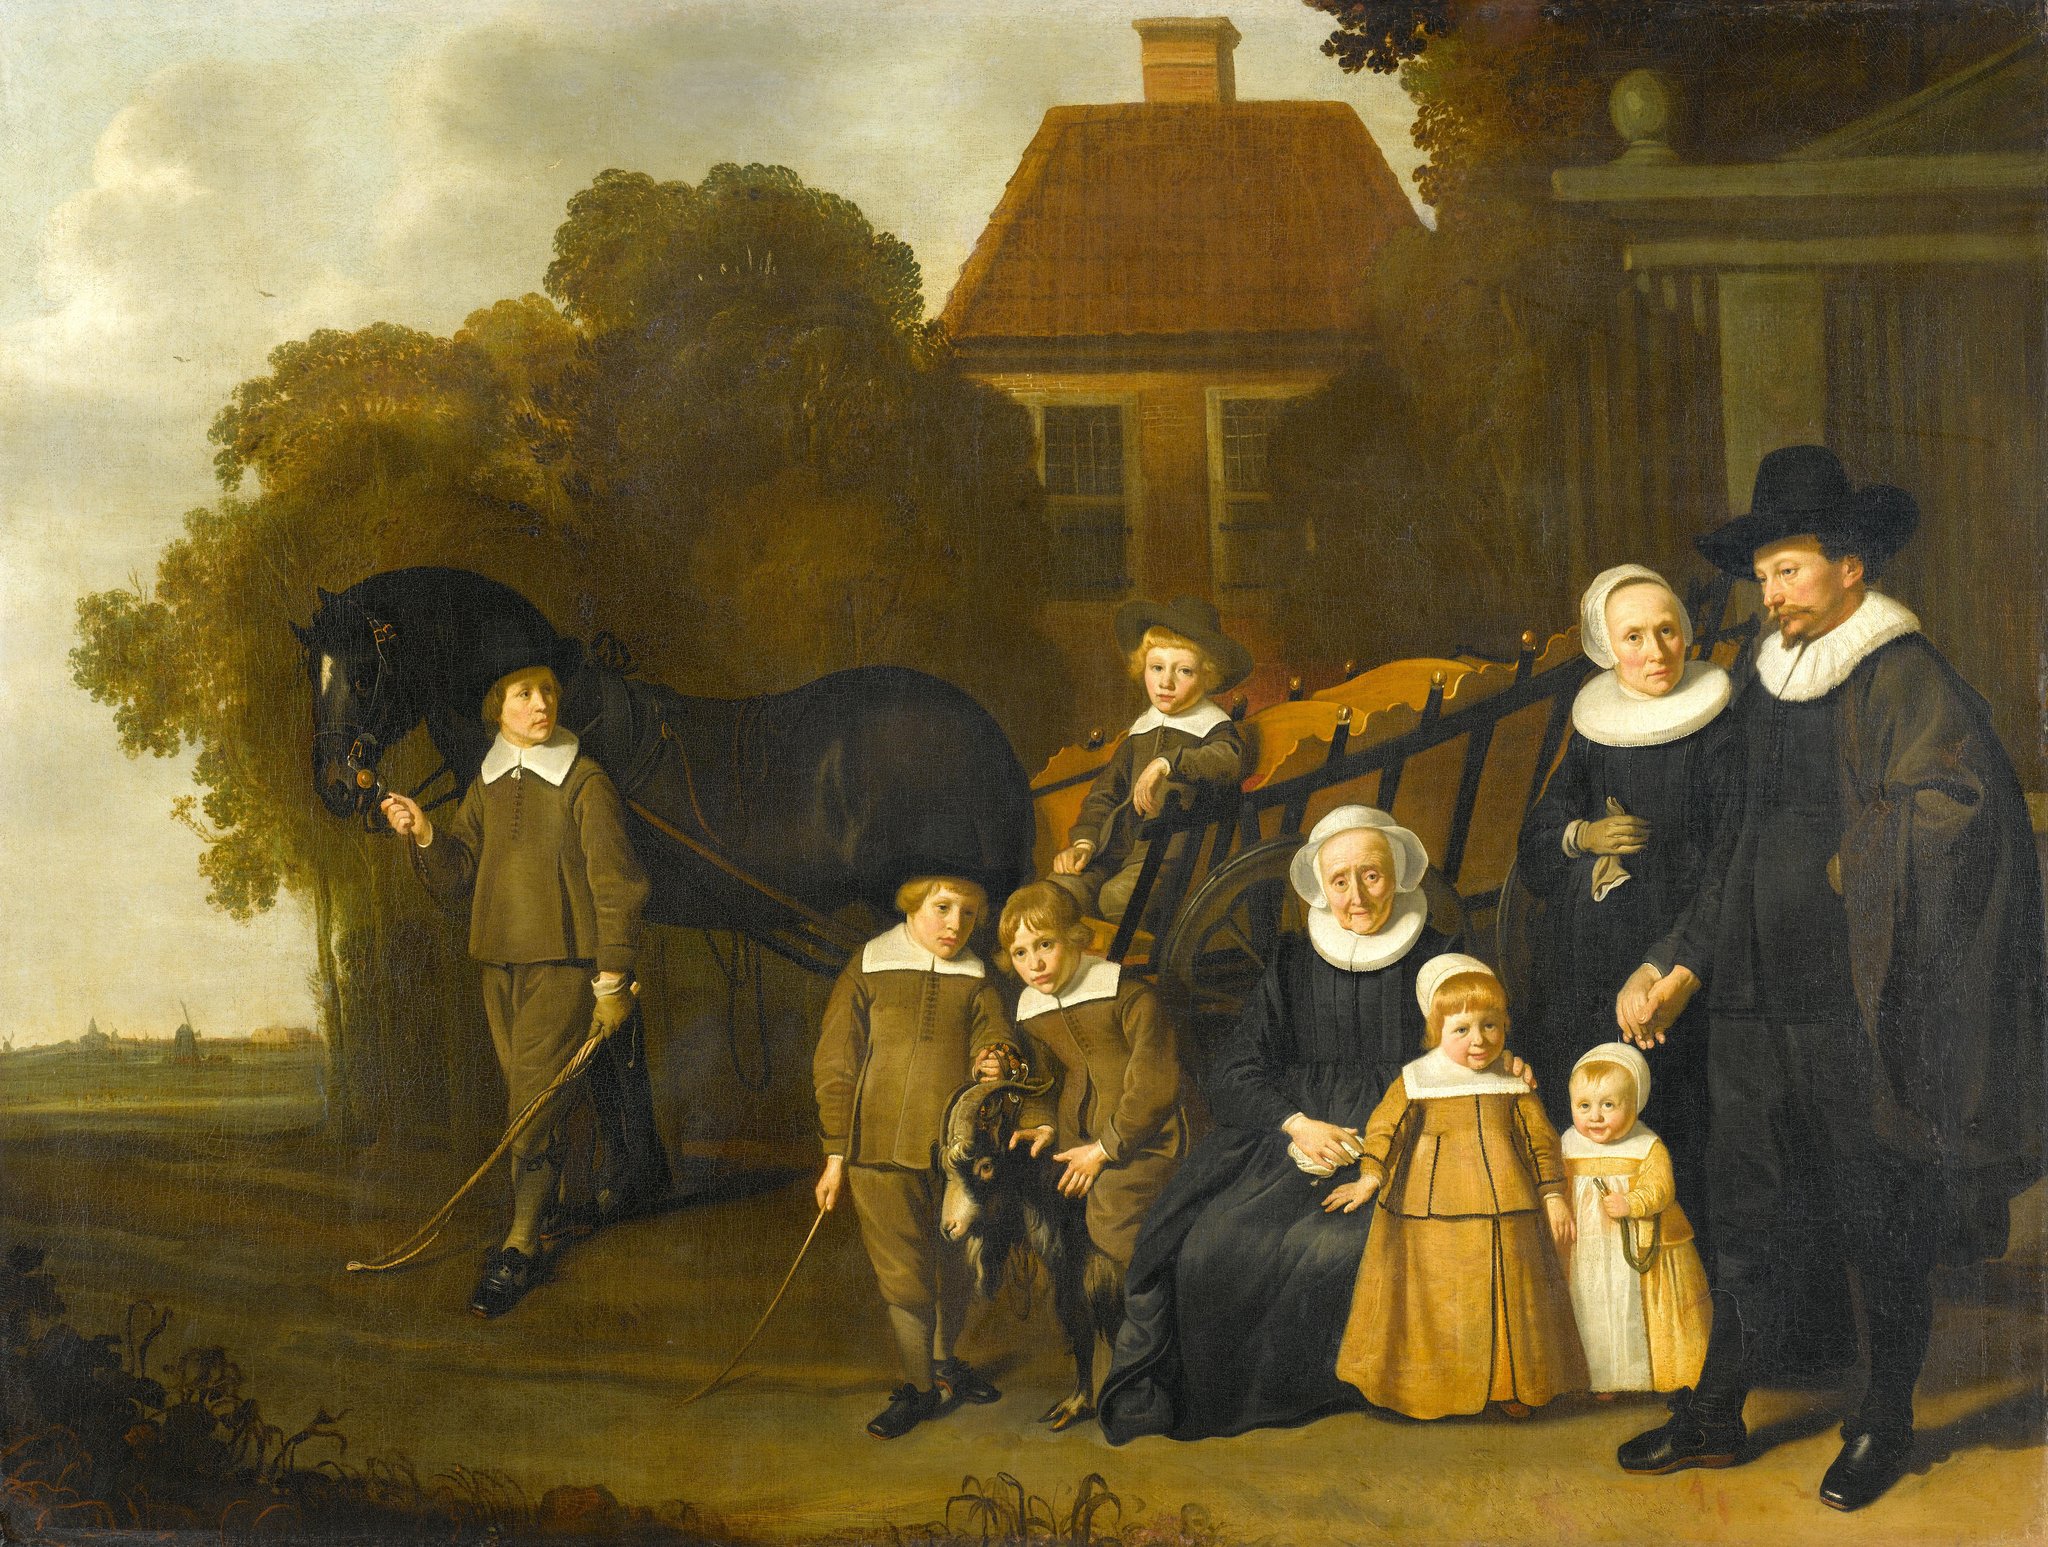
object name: painting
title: Portrait of the Meebeeck Cruywagen Family near the Gate of their Country Home on Uitweg near Amsterdam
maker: jacob van loo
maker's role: painter, print maker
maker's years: 1614-1670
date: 1640-1645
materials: canvas, oil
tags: historical persons - bb - woman, family group, especially parents with their child(ren), historical persons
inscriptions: inscription, on the reverse: ‘De Familieportretten verbeeld voor hunne hofstede aan den Hoge Dijk buiten den Haarlemmerpoort te Amsterdam, van het geslagt van Meebeek Kruywagen, huisvrouw van Jan Troost, curator der desolate boedelkamer te Amsterdam. Zij is begraven den 15 december 1699 in de N. Kerk en was de moeder van Cornelis Troost, kunstschilder’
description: Groepsportret van de familie Meebeeck Cruywagen bij de poort van hun buitenhuis aan de Uitweg bij Amsterdam. Twee van de jongens met een paard met wagen. Voorgesteld zijn, van links naar rechts: Cornelis, Pieter, Jan, Claas (op de wagen), Niesje Claesdr, de grootmoeder van de moederskant, Jacob, Rijckert, Barbara Jansdr née Mastenbroek (de moeder) en de vader Hendrick Cruywagen.